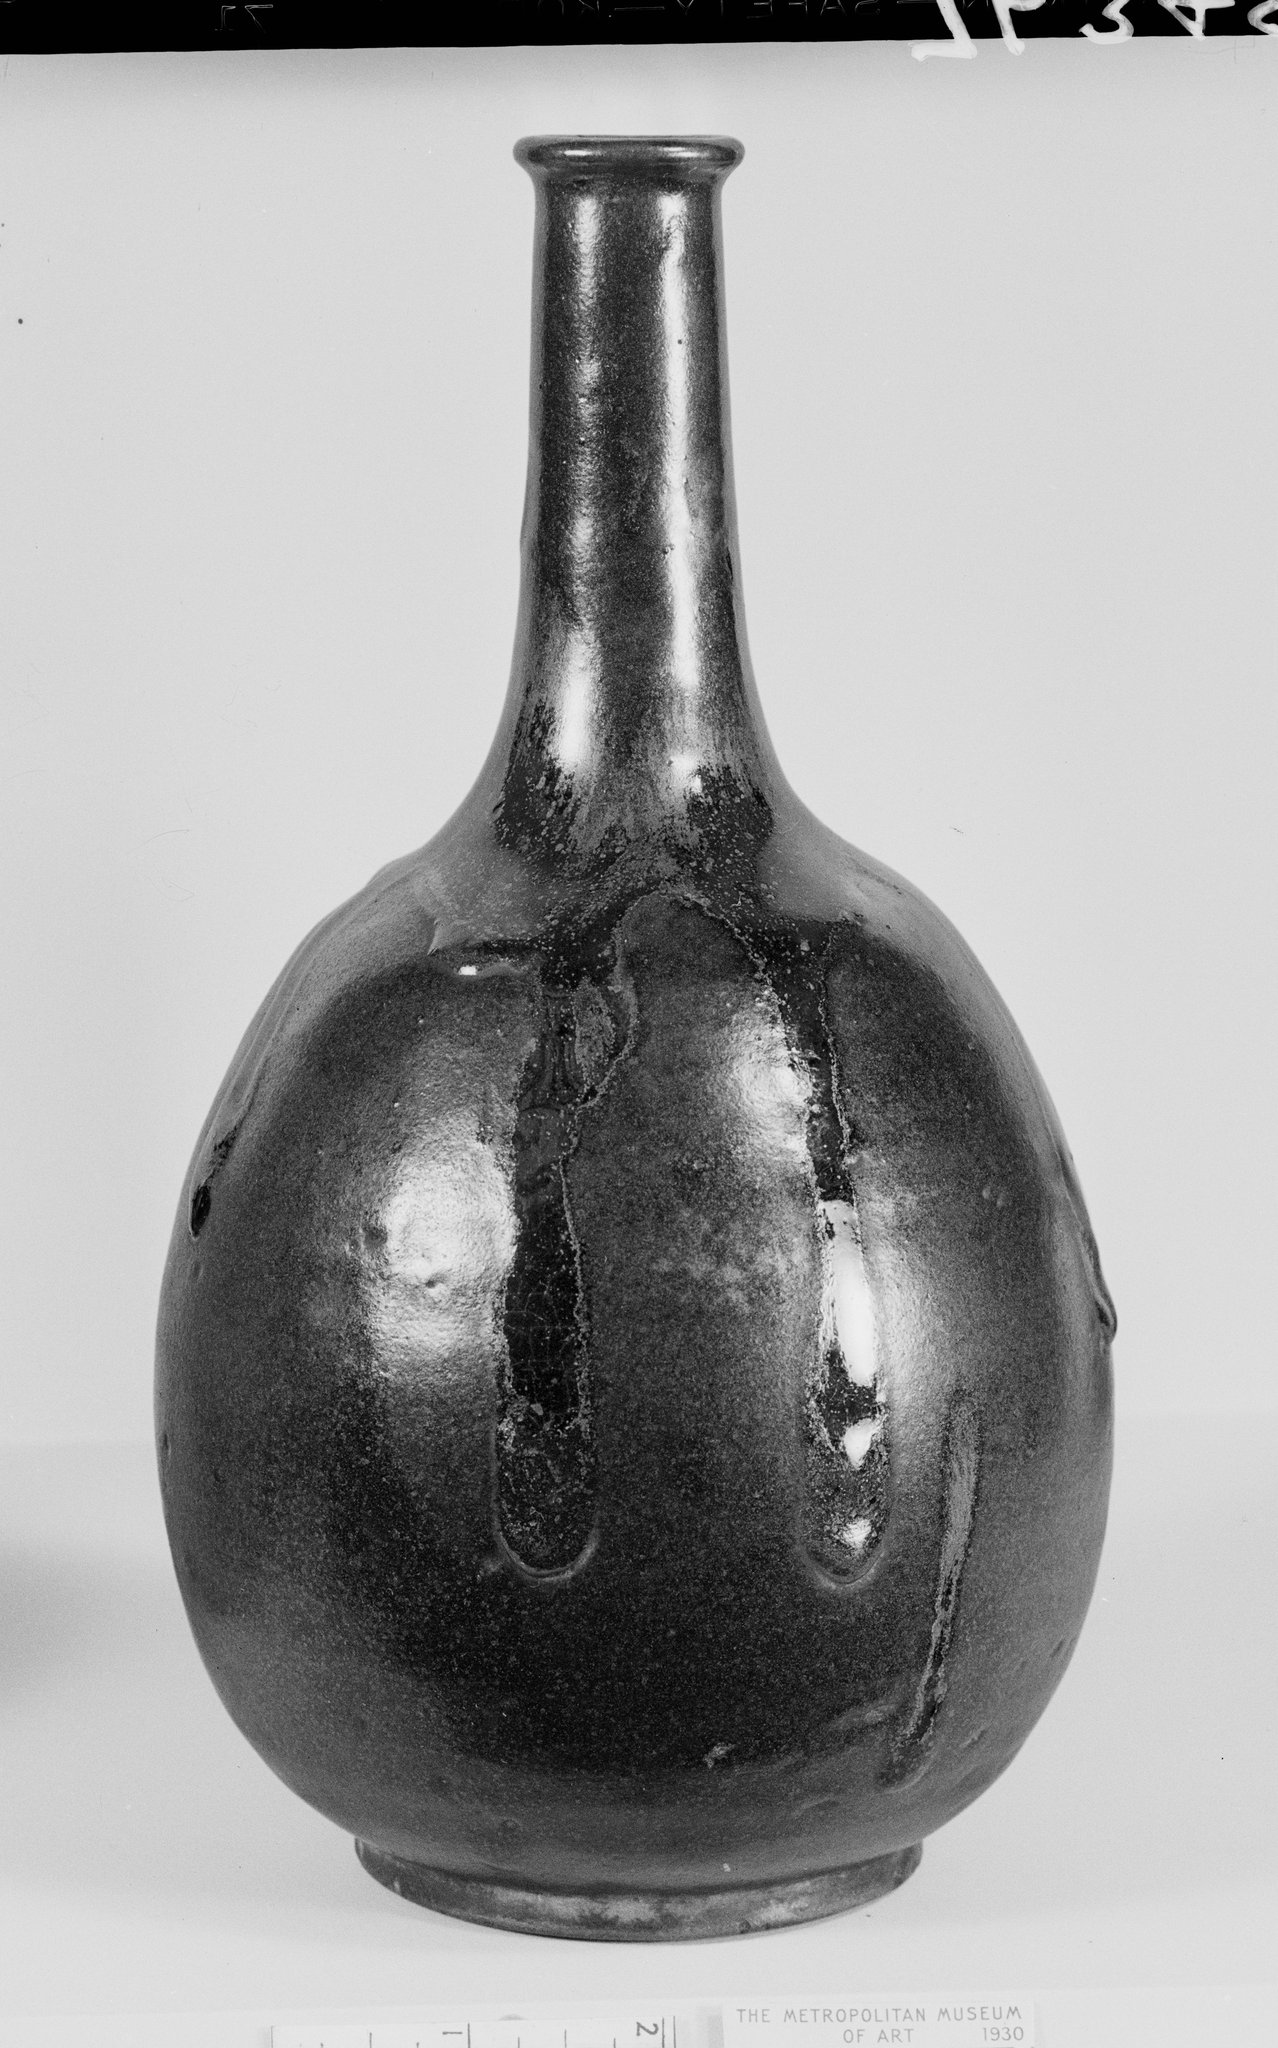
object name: bottle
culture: japanese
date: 1700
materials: clay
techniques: overglaze, underglaze